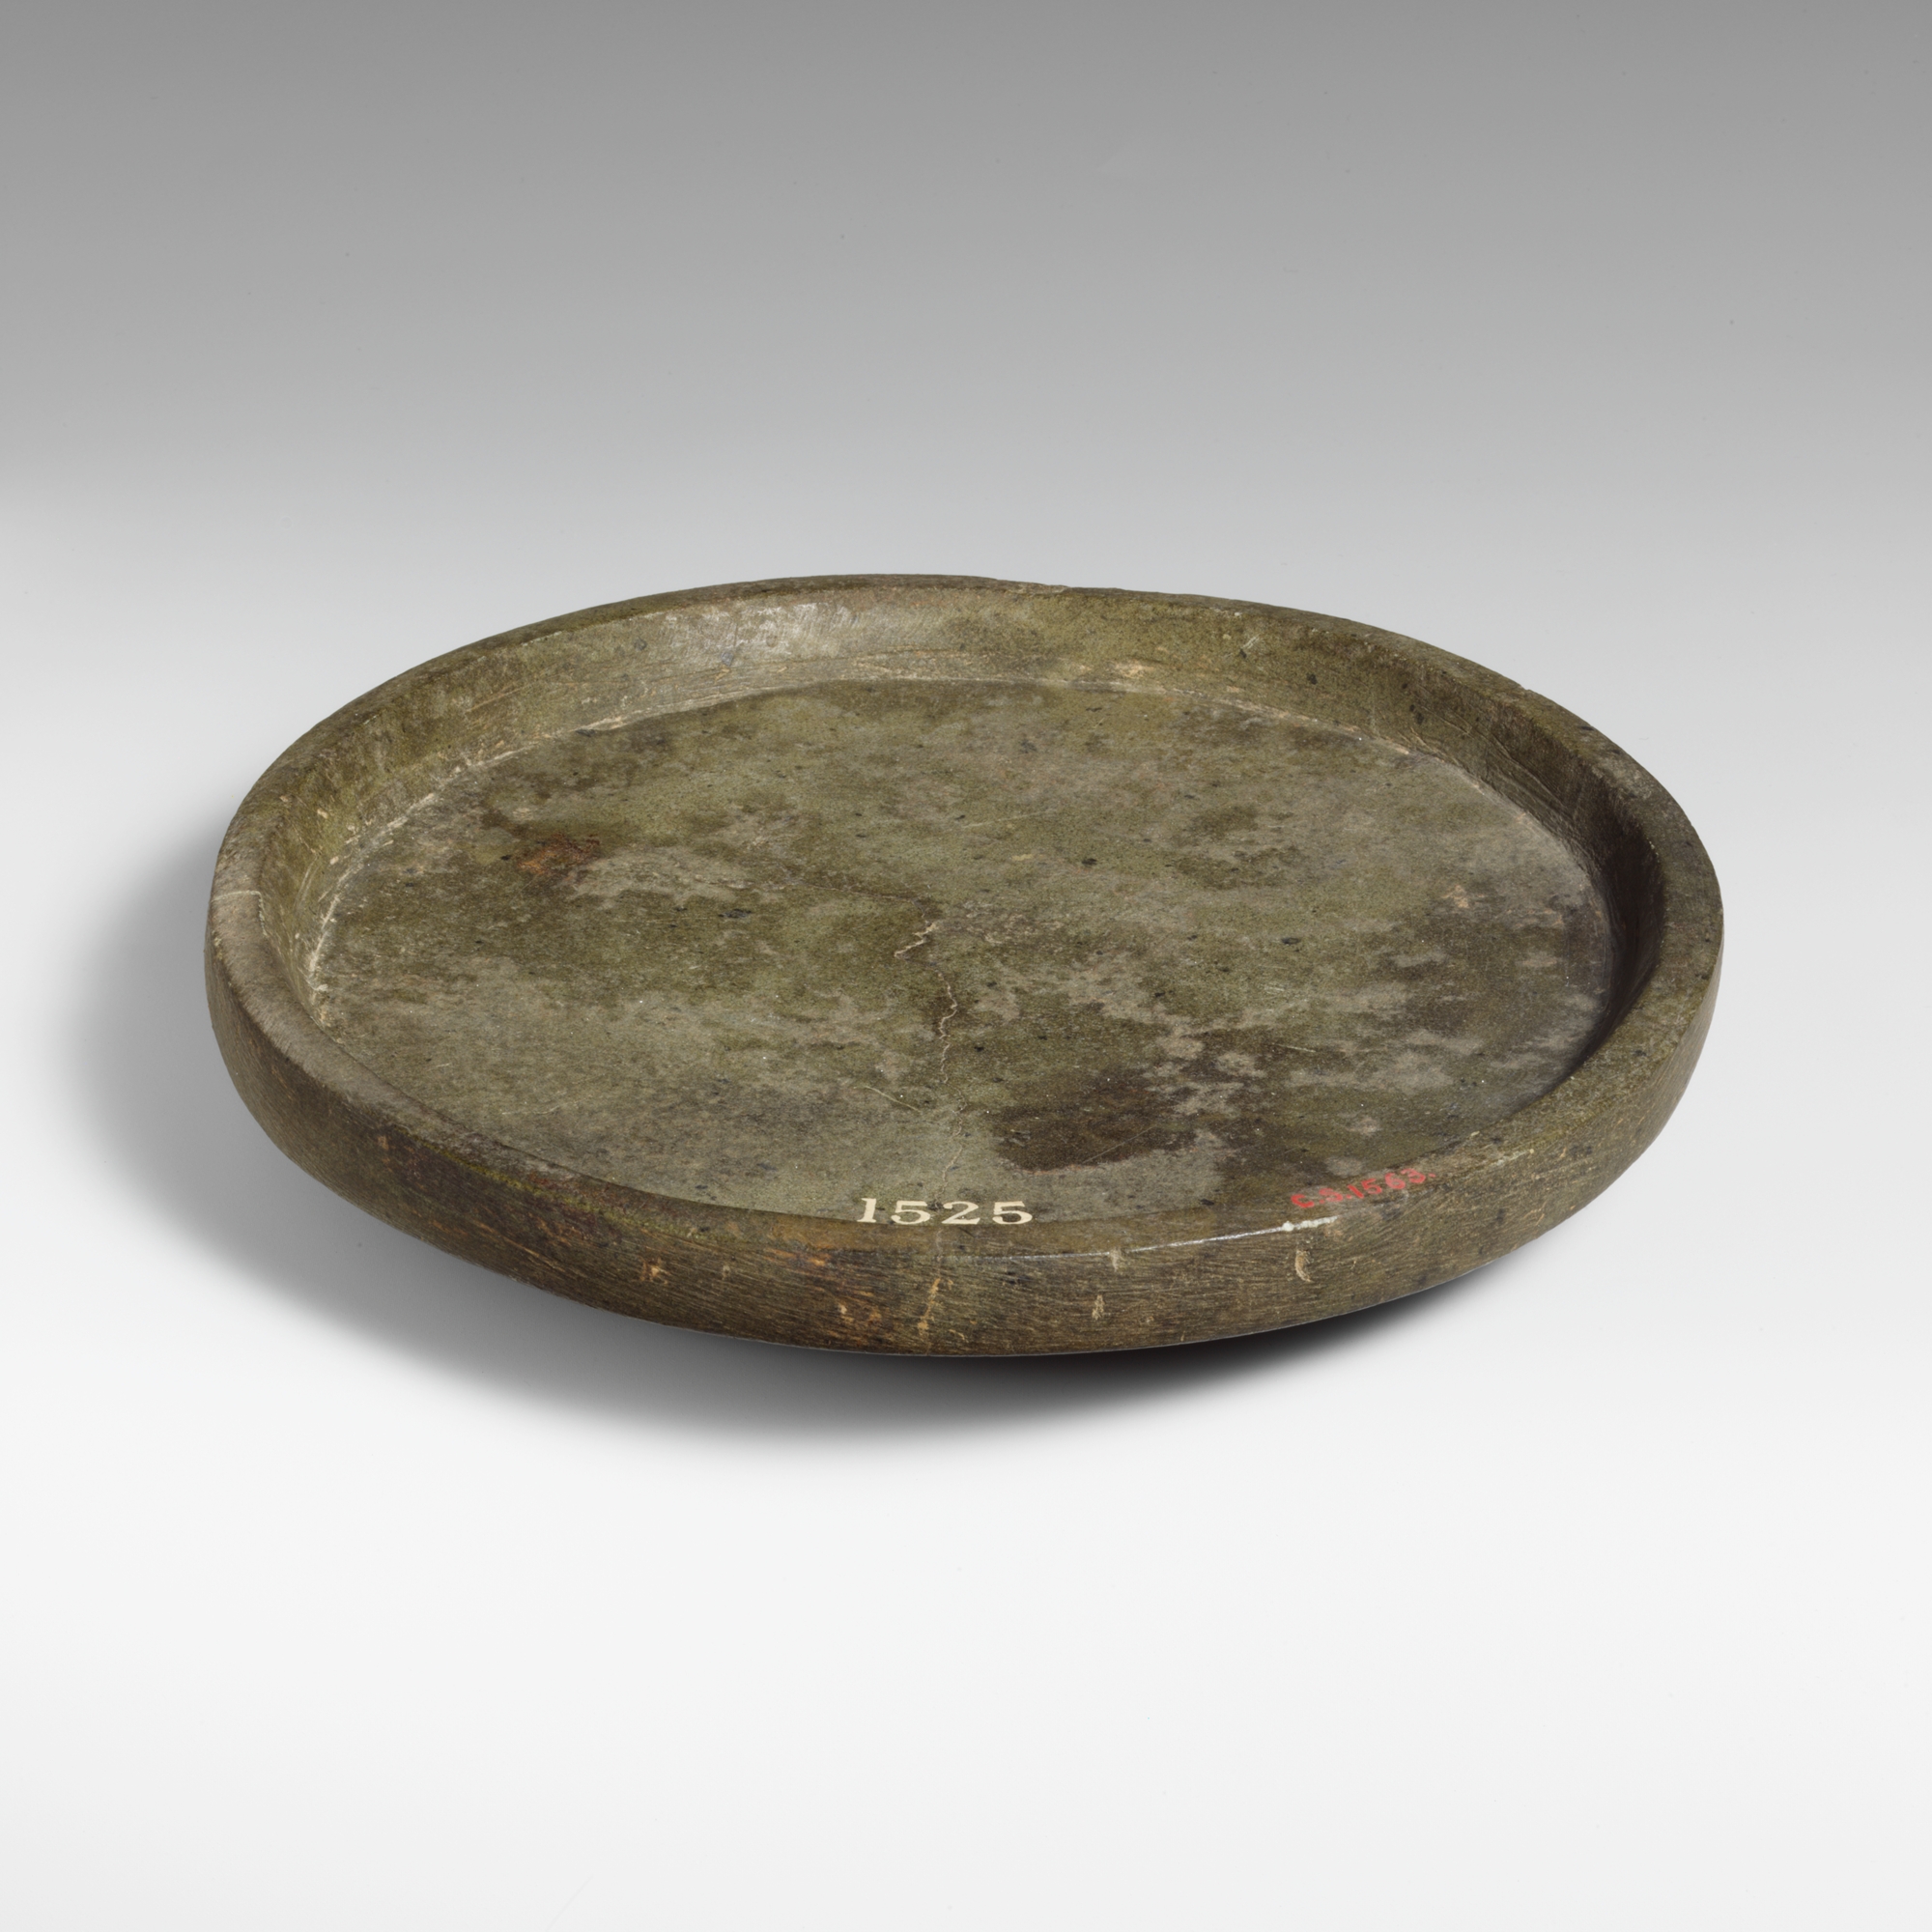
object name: plate or palette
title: Chlorite mortar or plate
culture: cypriot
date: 1600-1050 BCE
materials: mineral